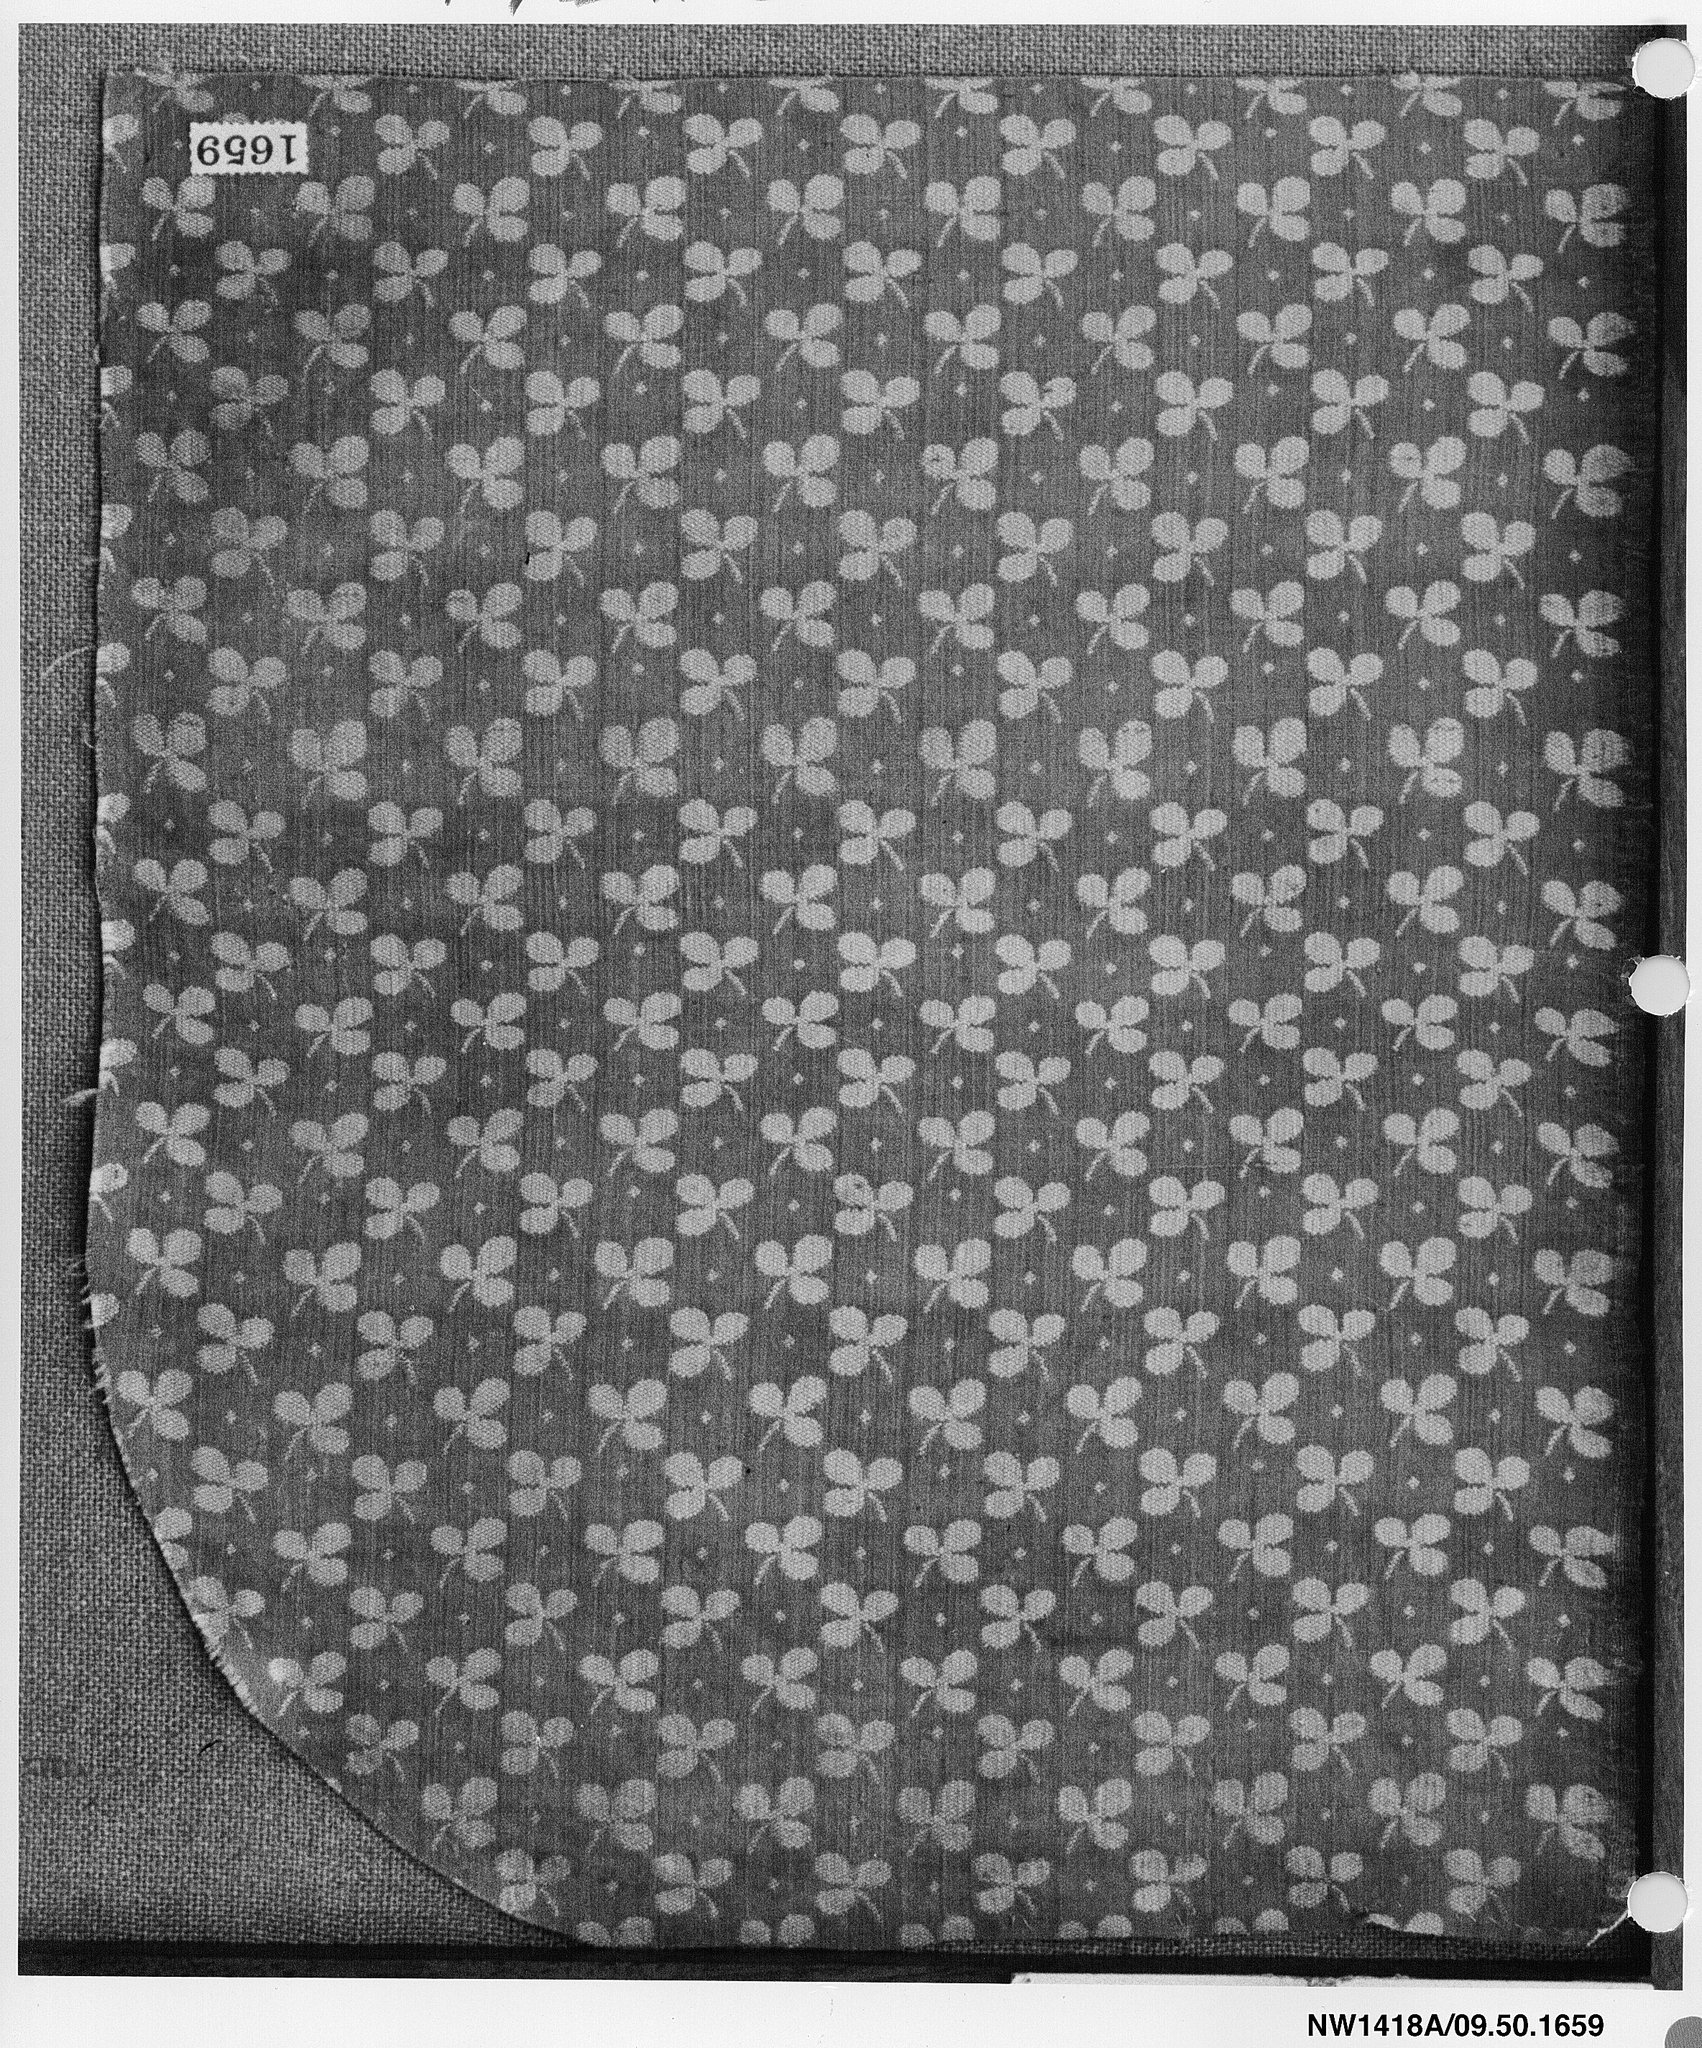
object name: piece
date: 1701-1800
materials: silk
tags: leaves